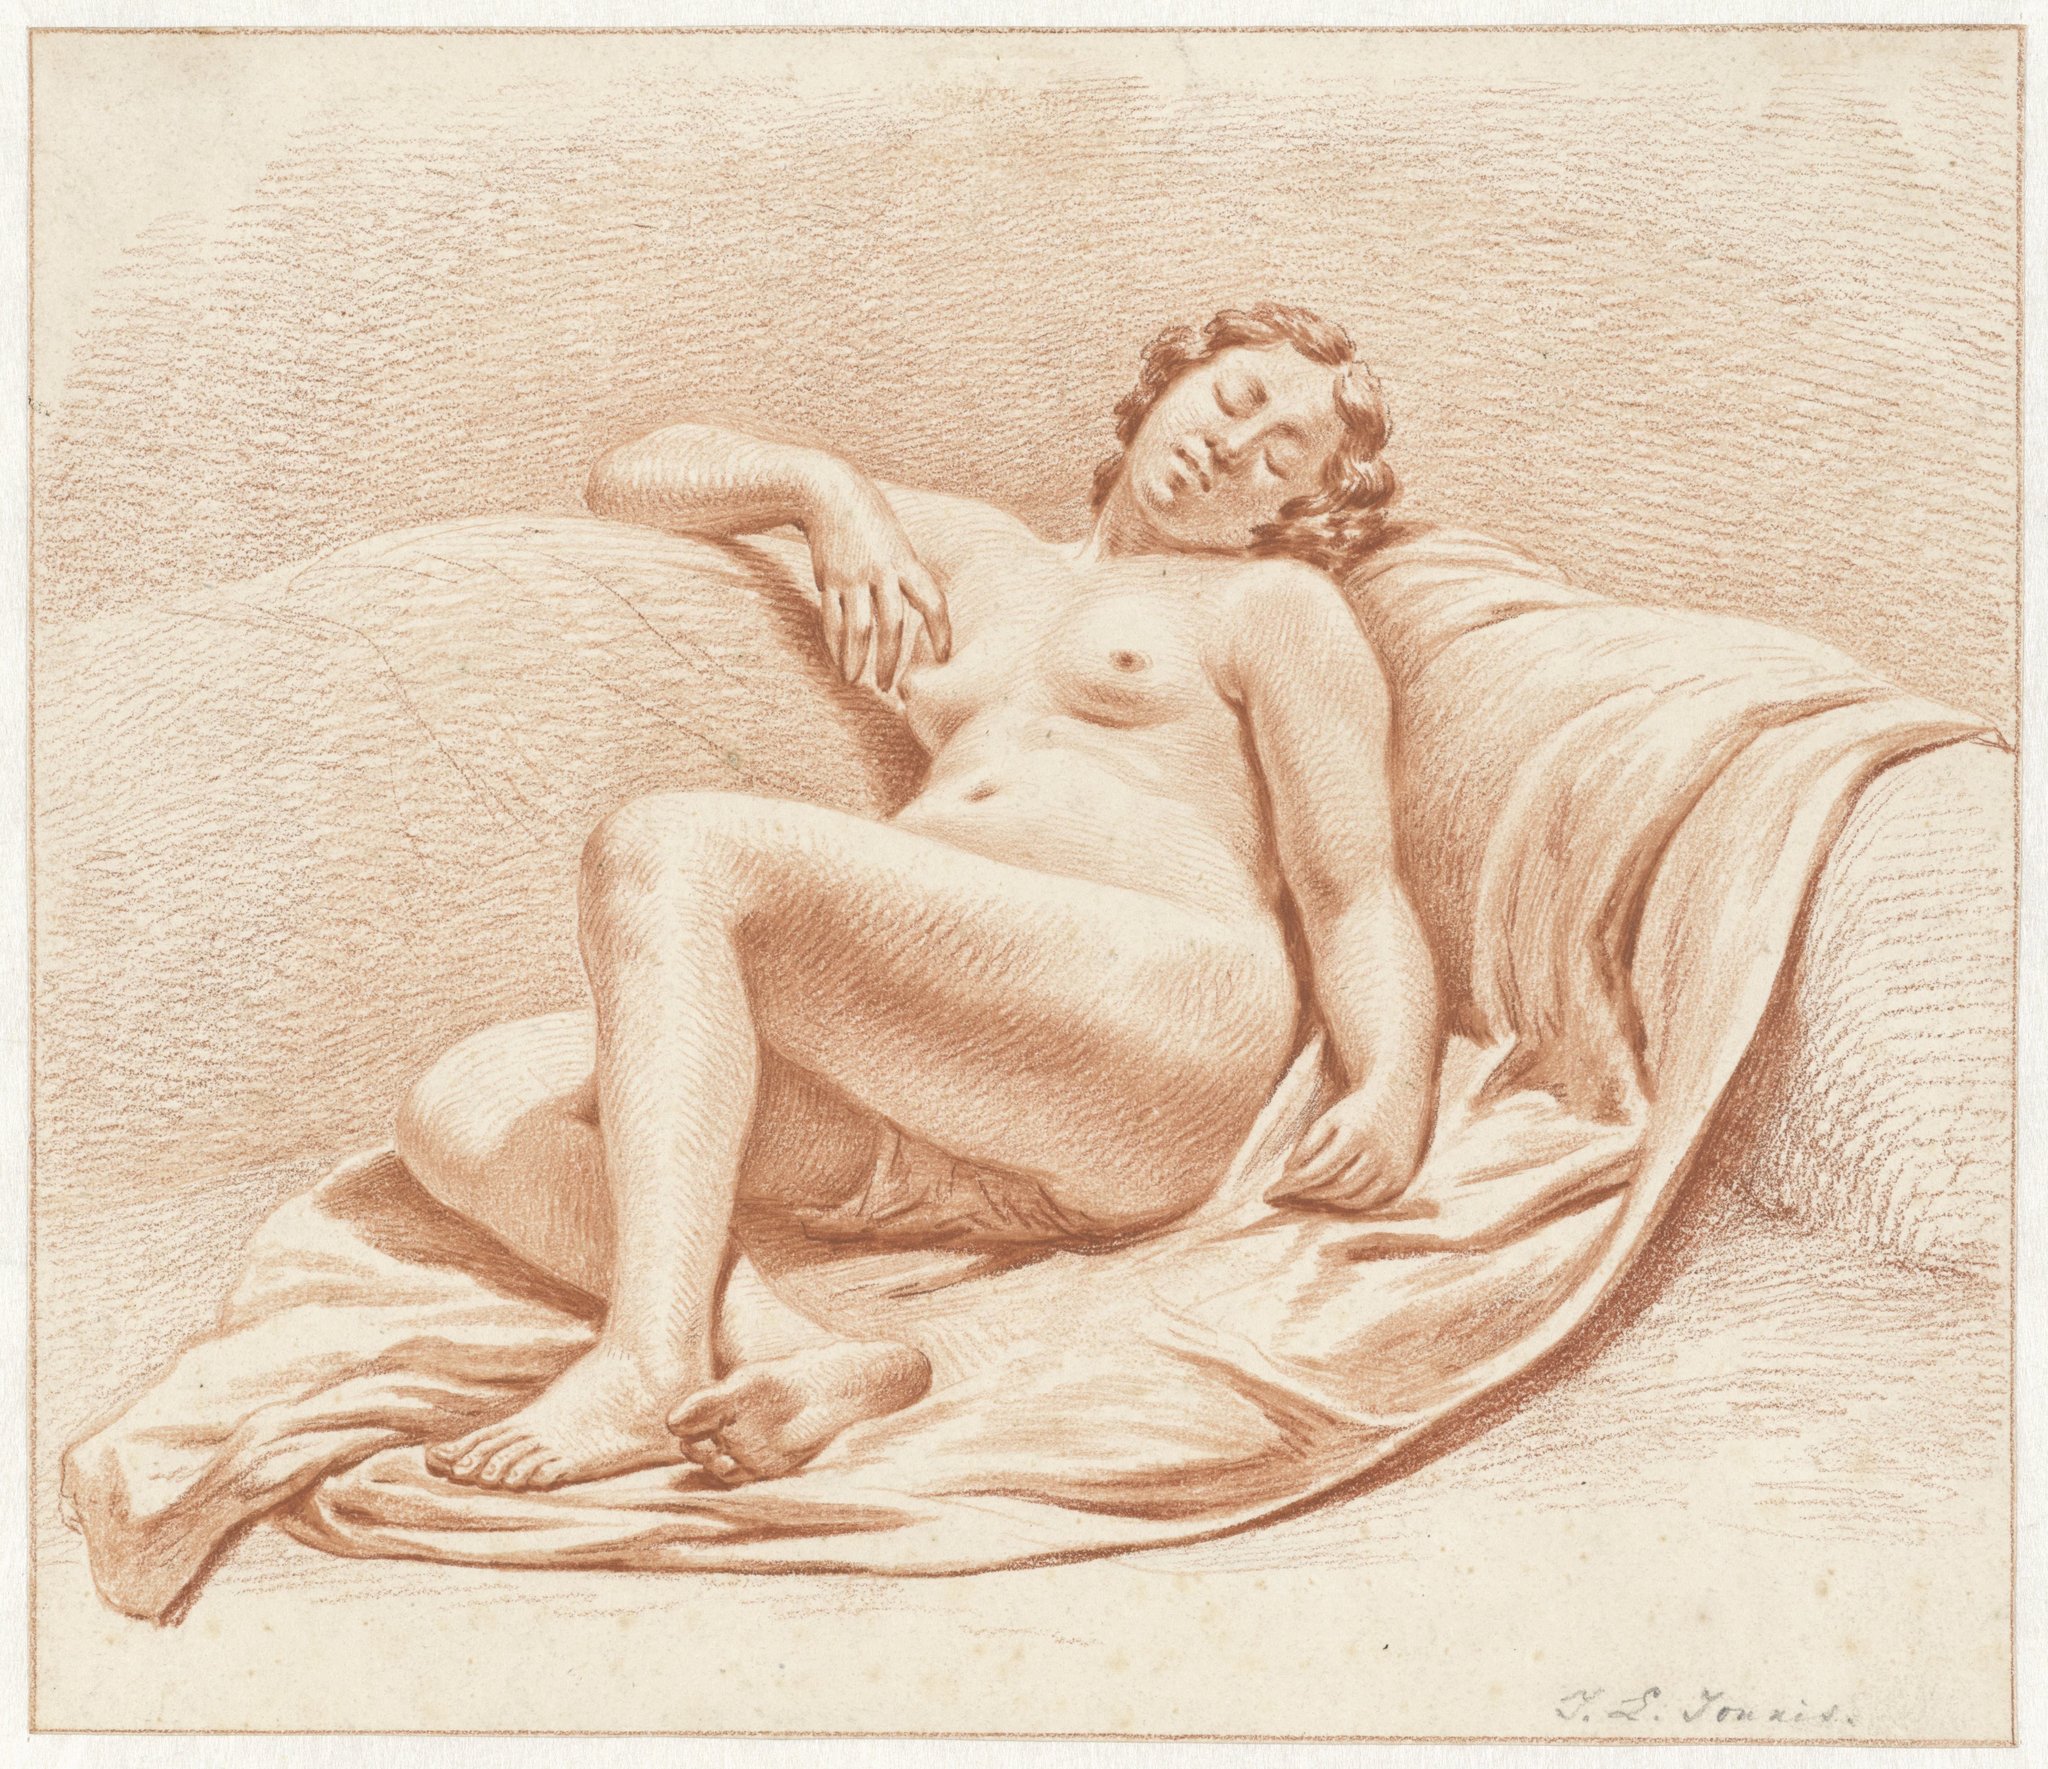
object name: drawing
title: Reclining Female Nude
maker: jan lodewijk jonxis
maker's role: draughtsman, painter, print maker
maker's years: 1789-1867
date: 1799-1867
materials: chalk, paper